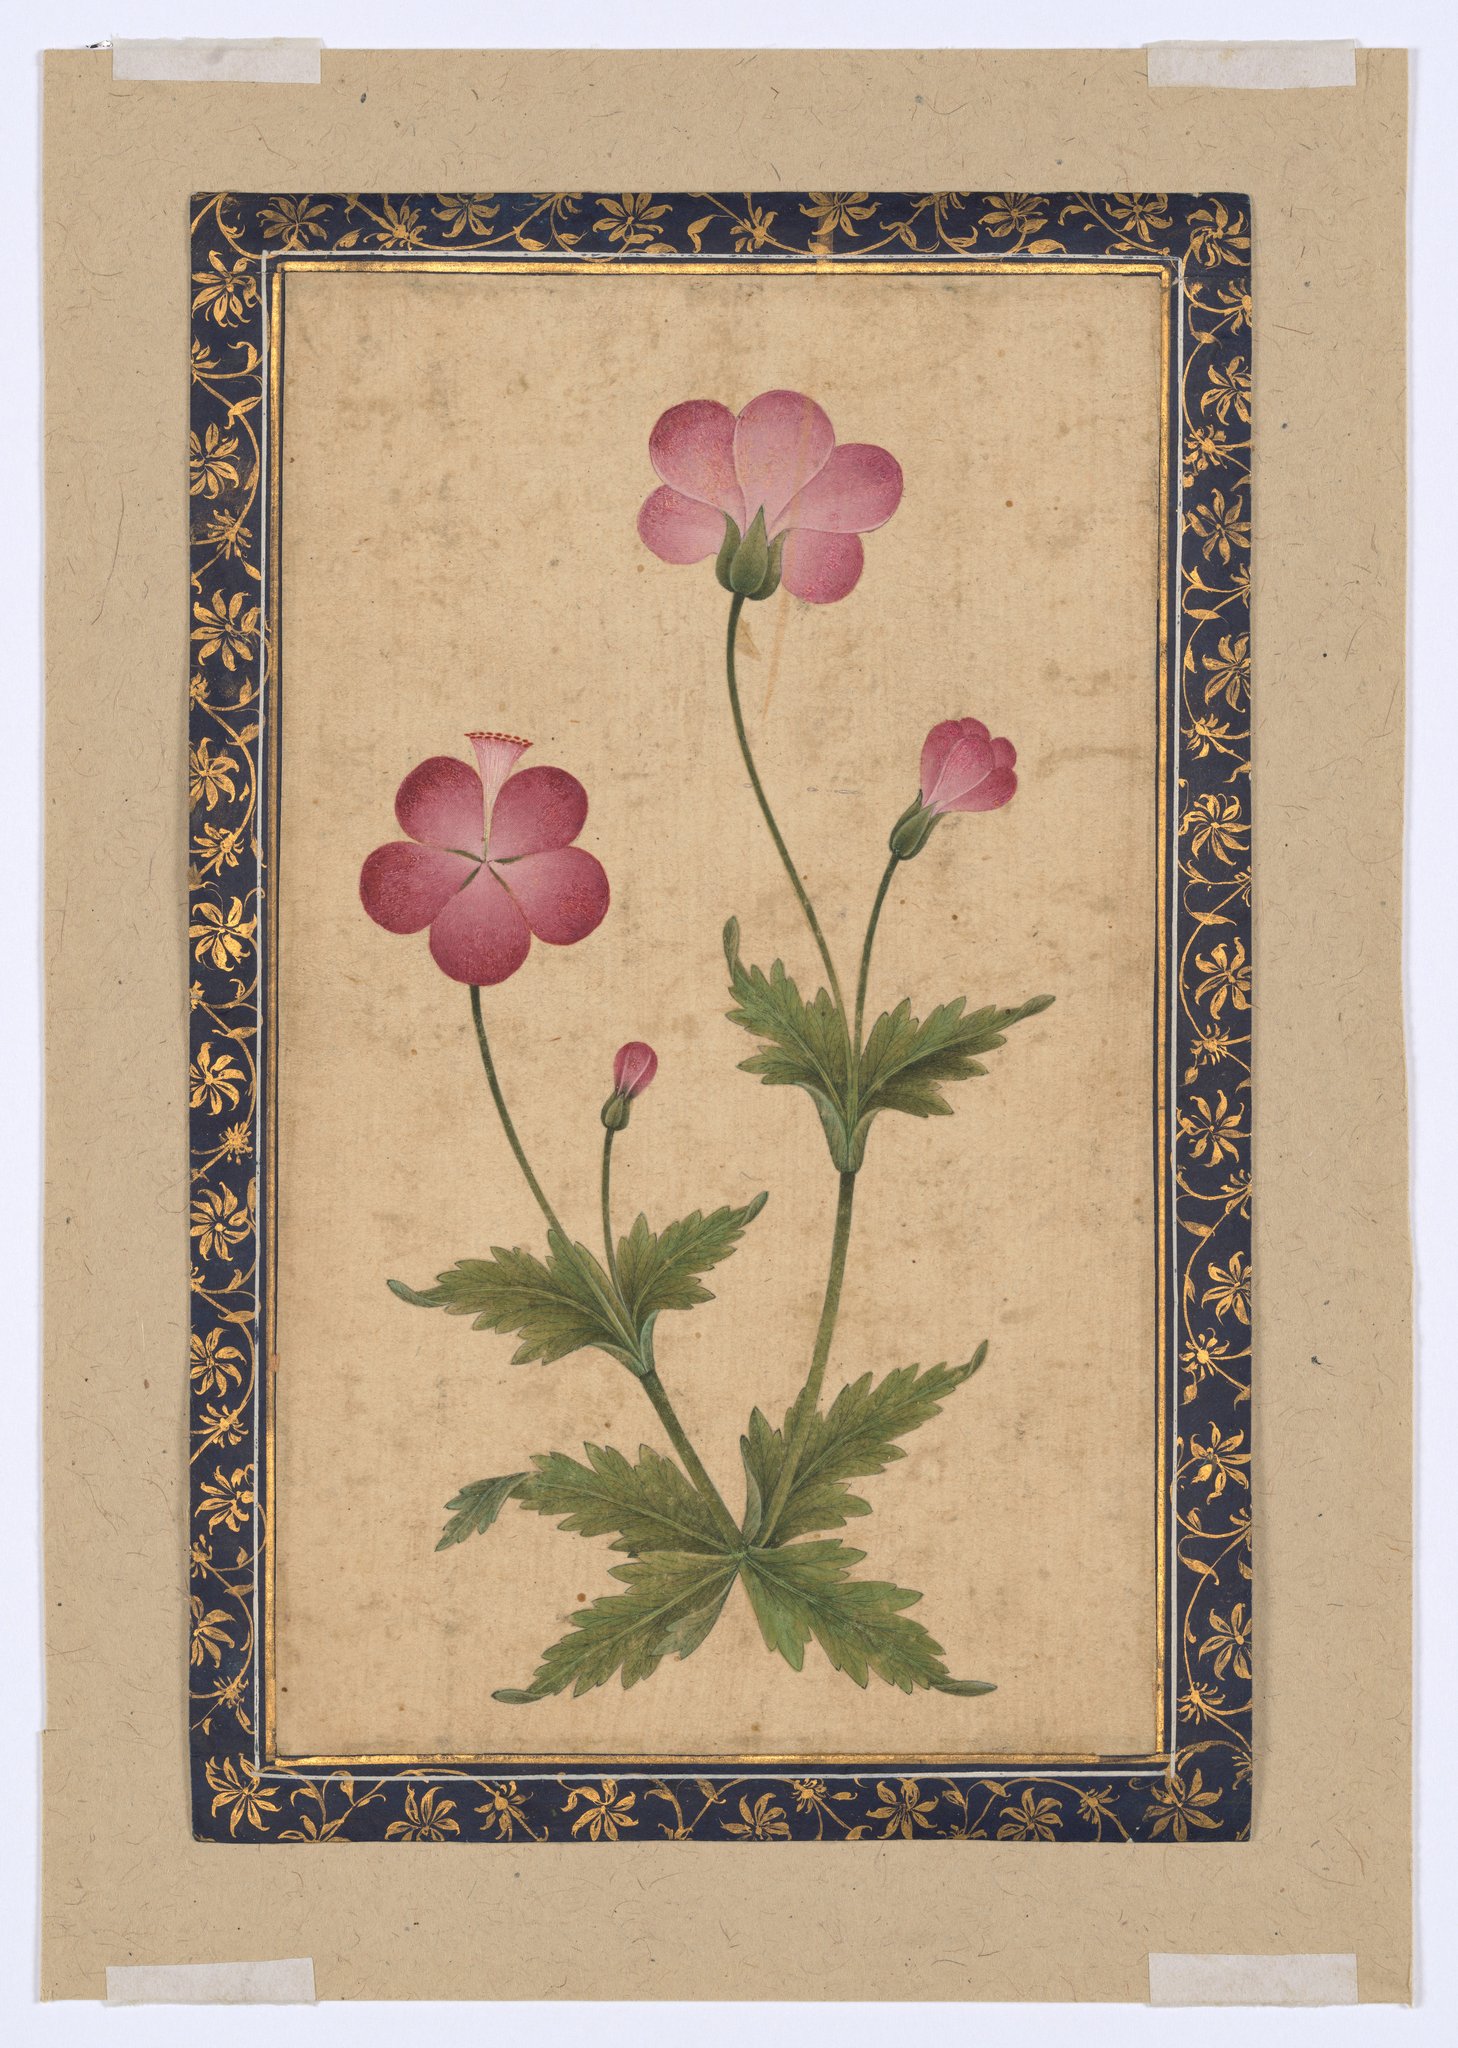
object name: illustrated single work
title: Botanical Painting: Composite Flower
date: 1630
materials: paper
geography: india